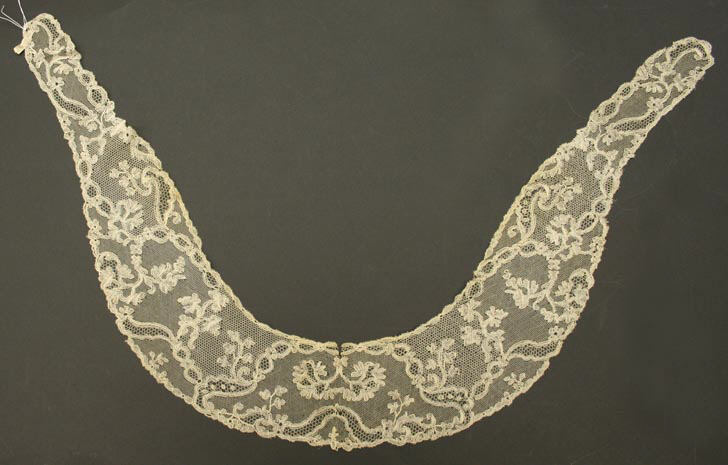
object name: fichu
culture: british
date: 1801-1900